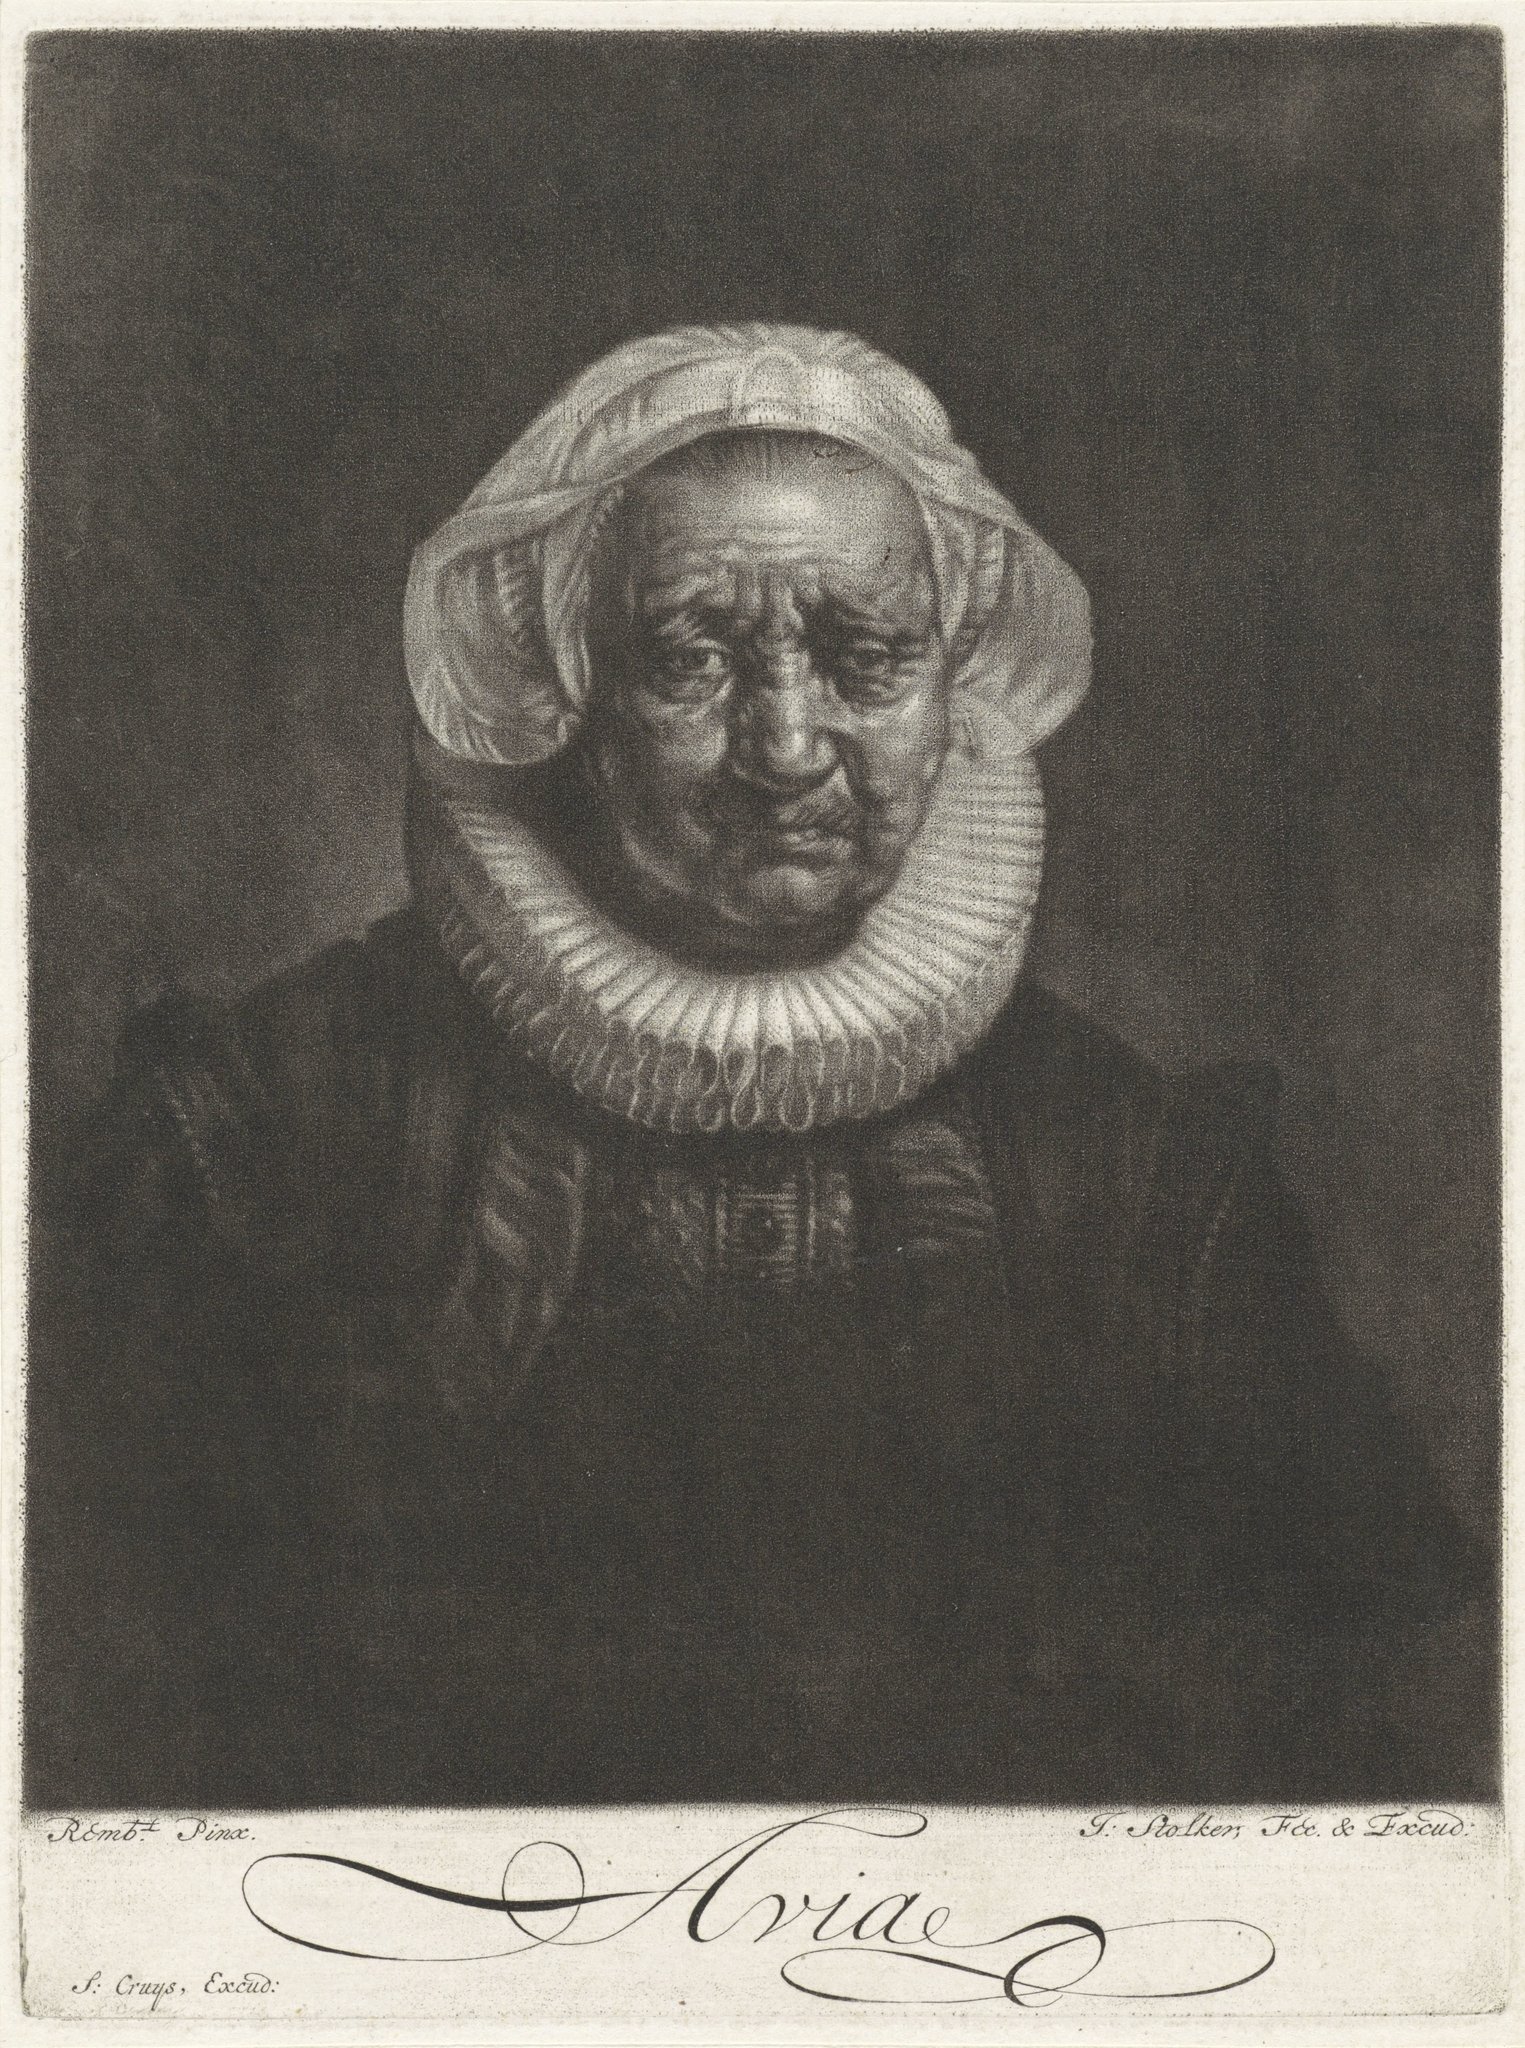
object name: print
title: Avia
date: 1734-1785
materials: paper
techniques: engraving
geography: northern netherlands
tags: aechje claesdr.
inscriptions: collector's mark: Lugt 2228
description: Portret van Aechje Claesdr., weduwe van de Rotterdamse bierbrouwer Jan Dammaszn. Pesser.